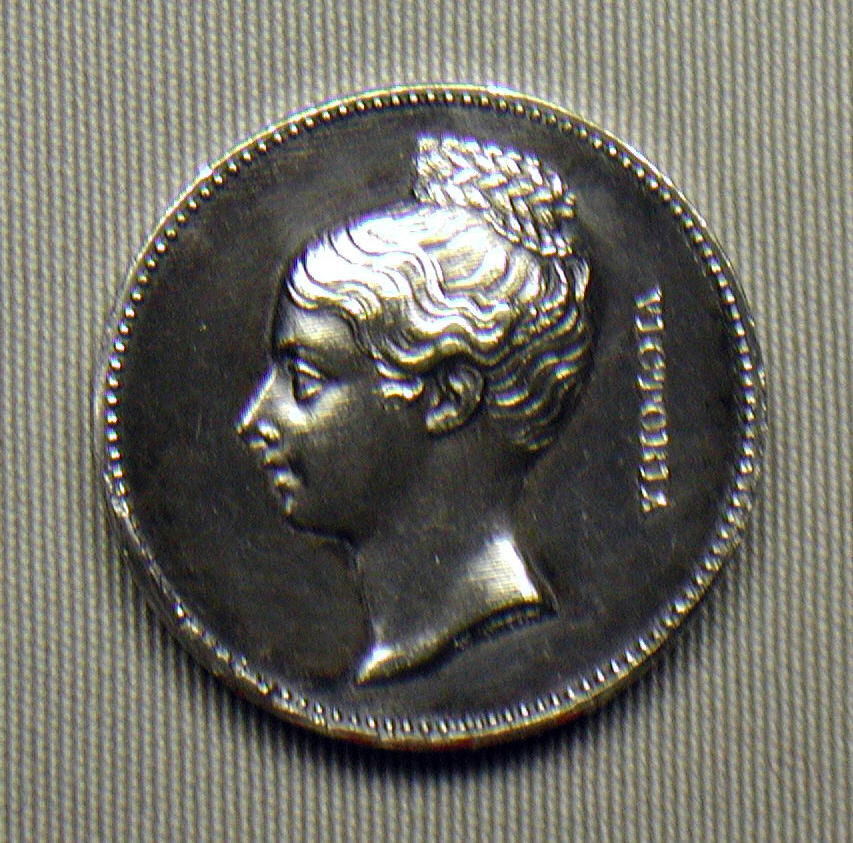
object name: medal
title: Queen Victoria's Visit to the Corporation of London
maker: william wyon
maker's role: artist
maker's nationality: british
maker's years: 1795-1851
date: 1837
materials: silver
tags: buildings,profiles,women,queen victoria